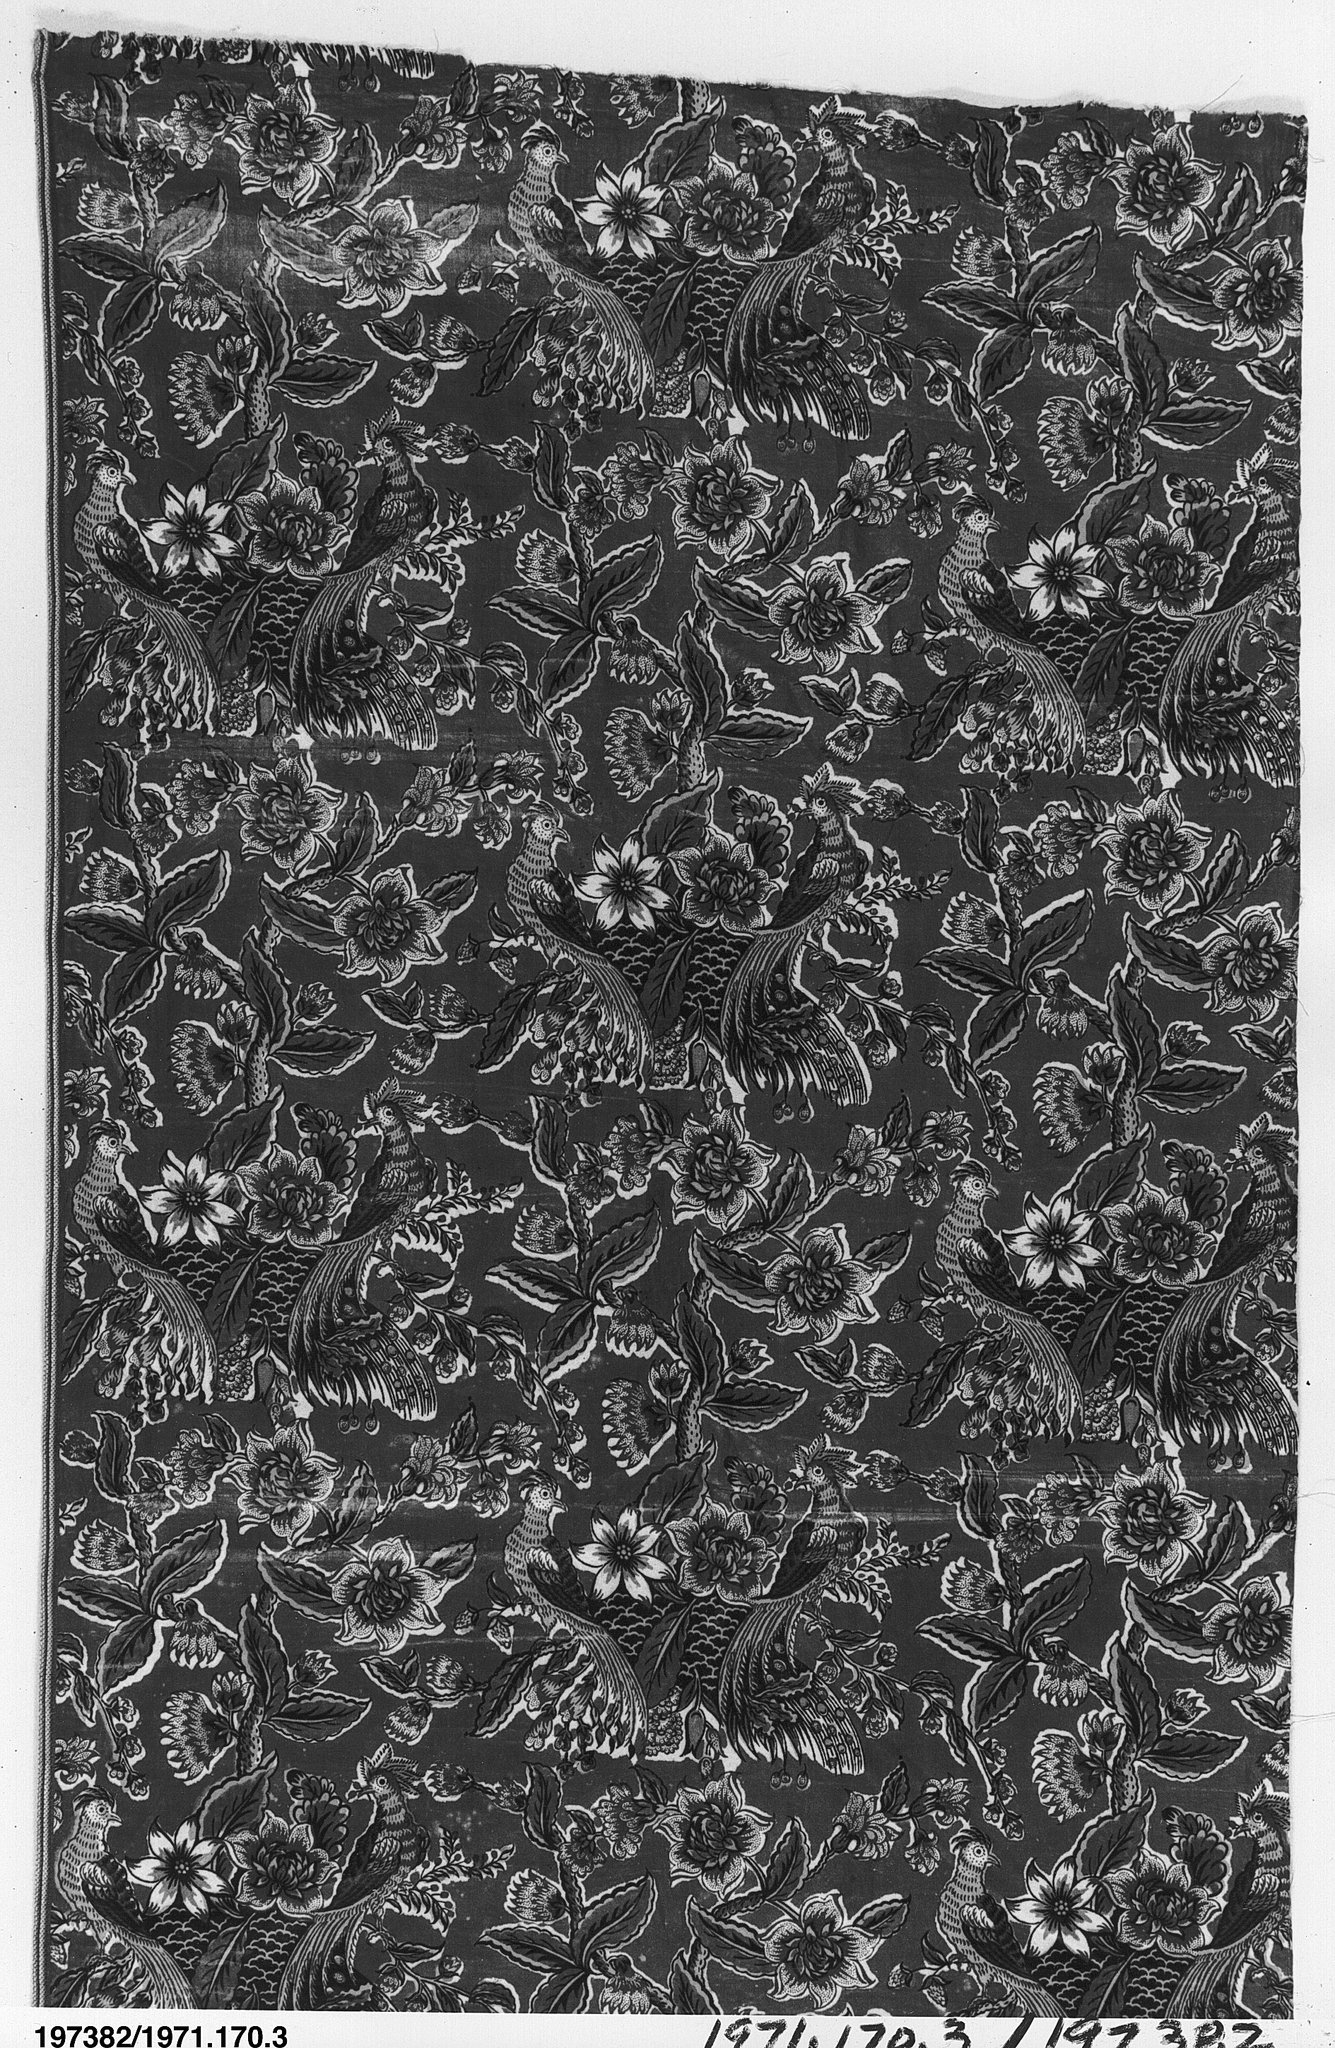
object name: piece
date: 1810-1815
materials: cotton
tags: birds,flowers,leaves